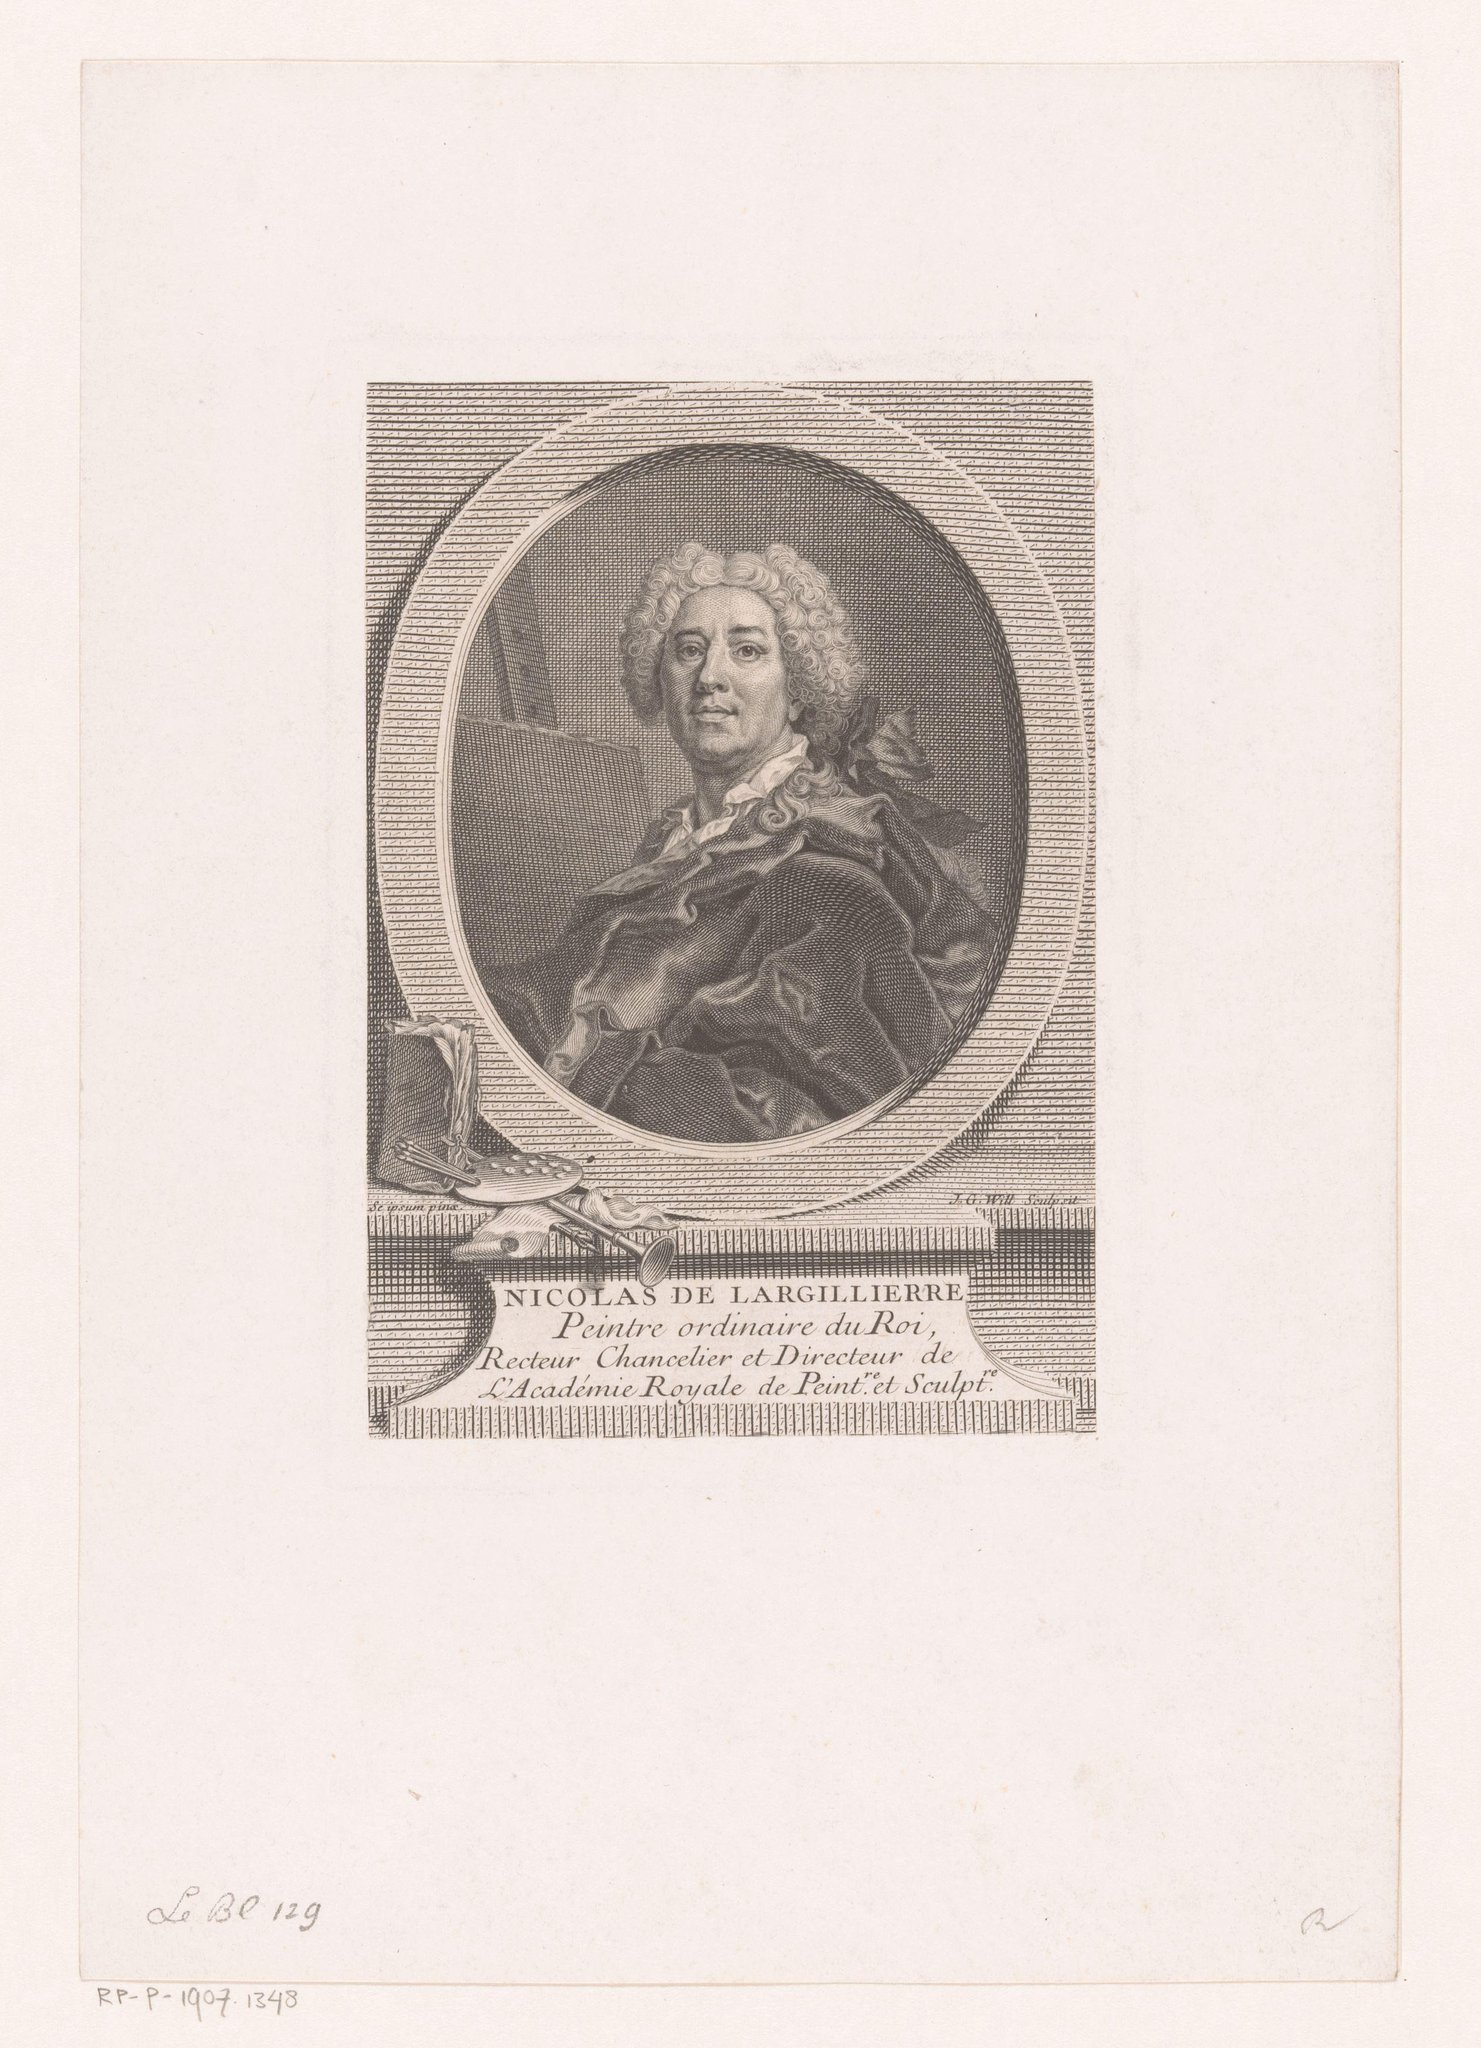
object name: print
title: Portret van Nicolas de Largillière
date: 1738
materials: paper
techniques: engraving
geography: france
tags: paris, painter, nicolas de largillière, historical persons, portrait, self-portrait of painter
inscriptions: collector's mark: Lugt 2228